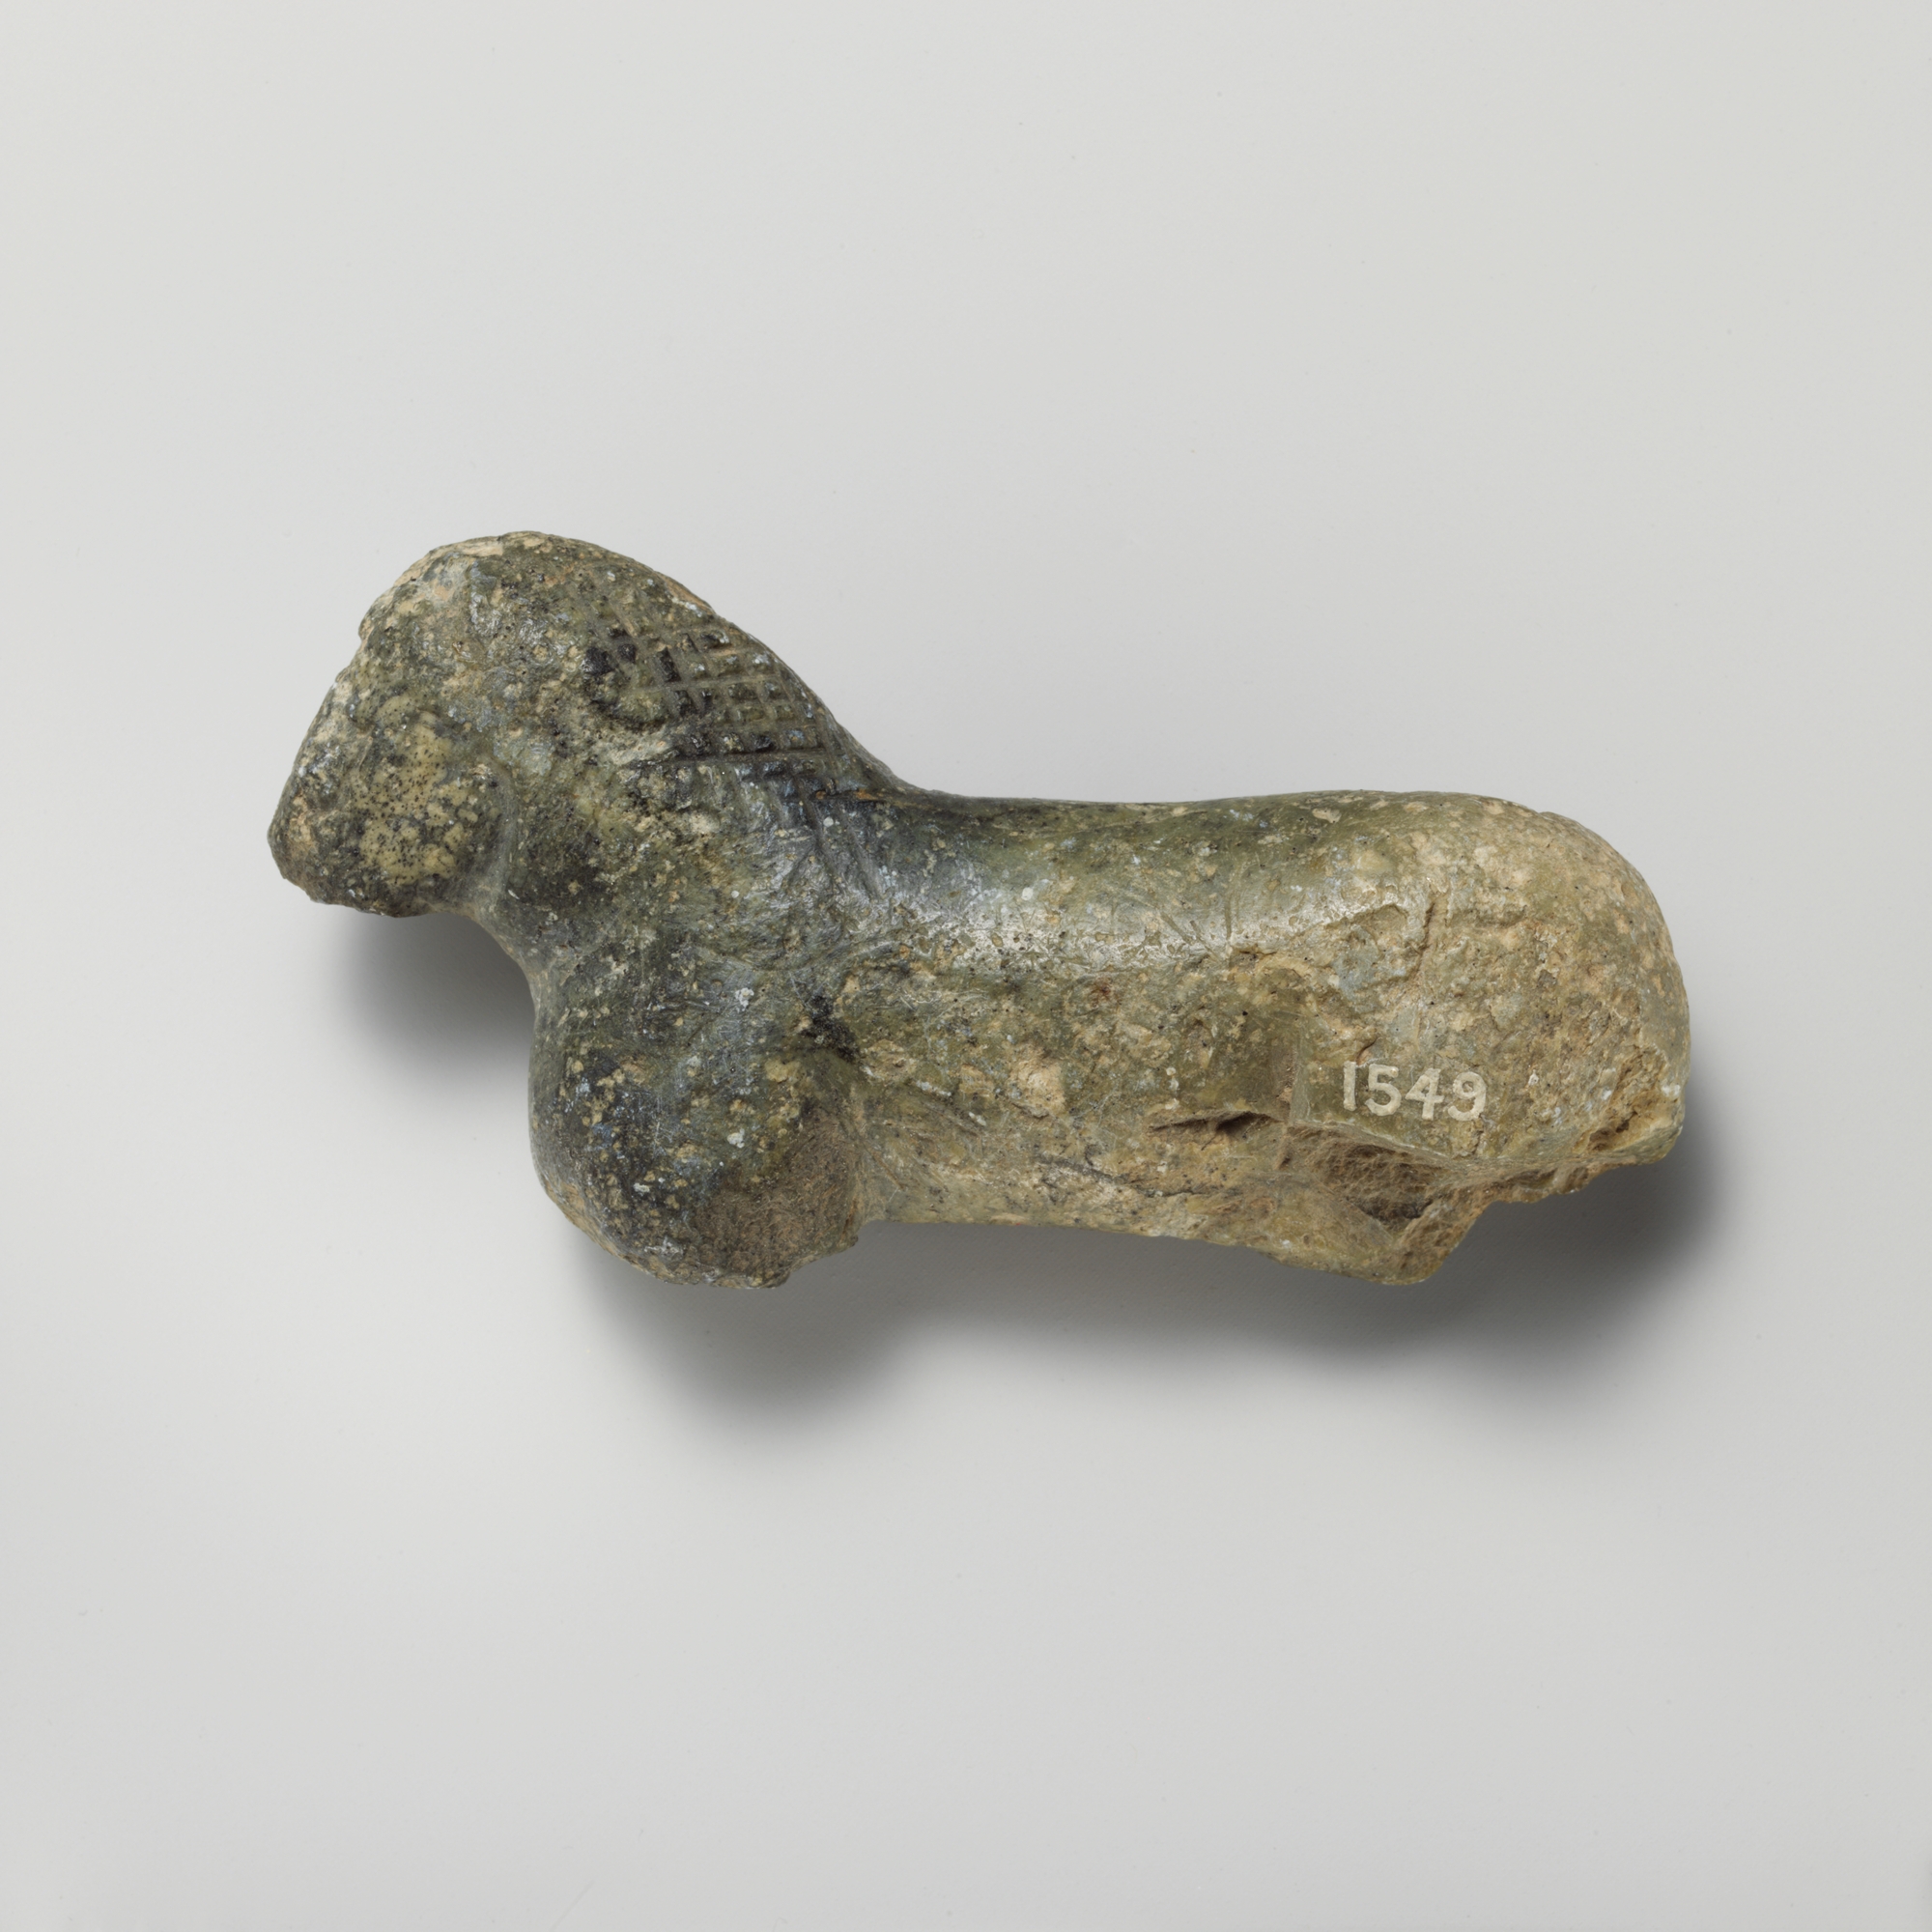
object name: statuette of a lion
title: Limestone horse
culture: cypriot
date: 3900-2500 BCE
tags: horses